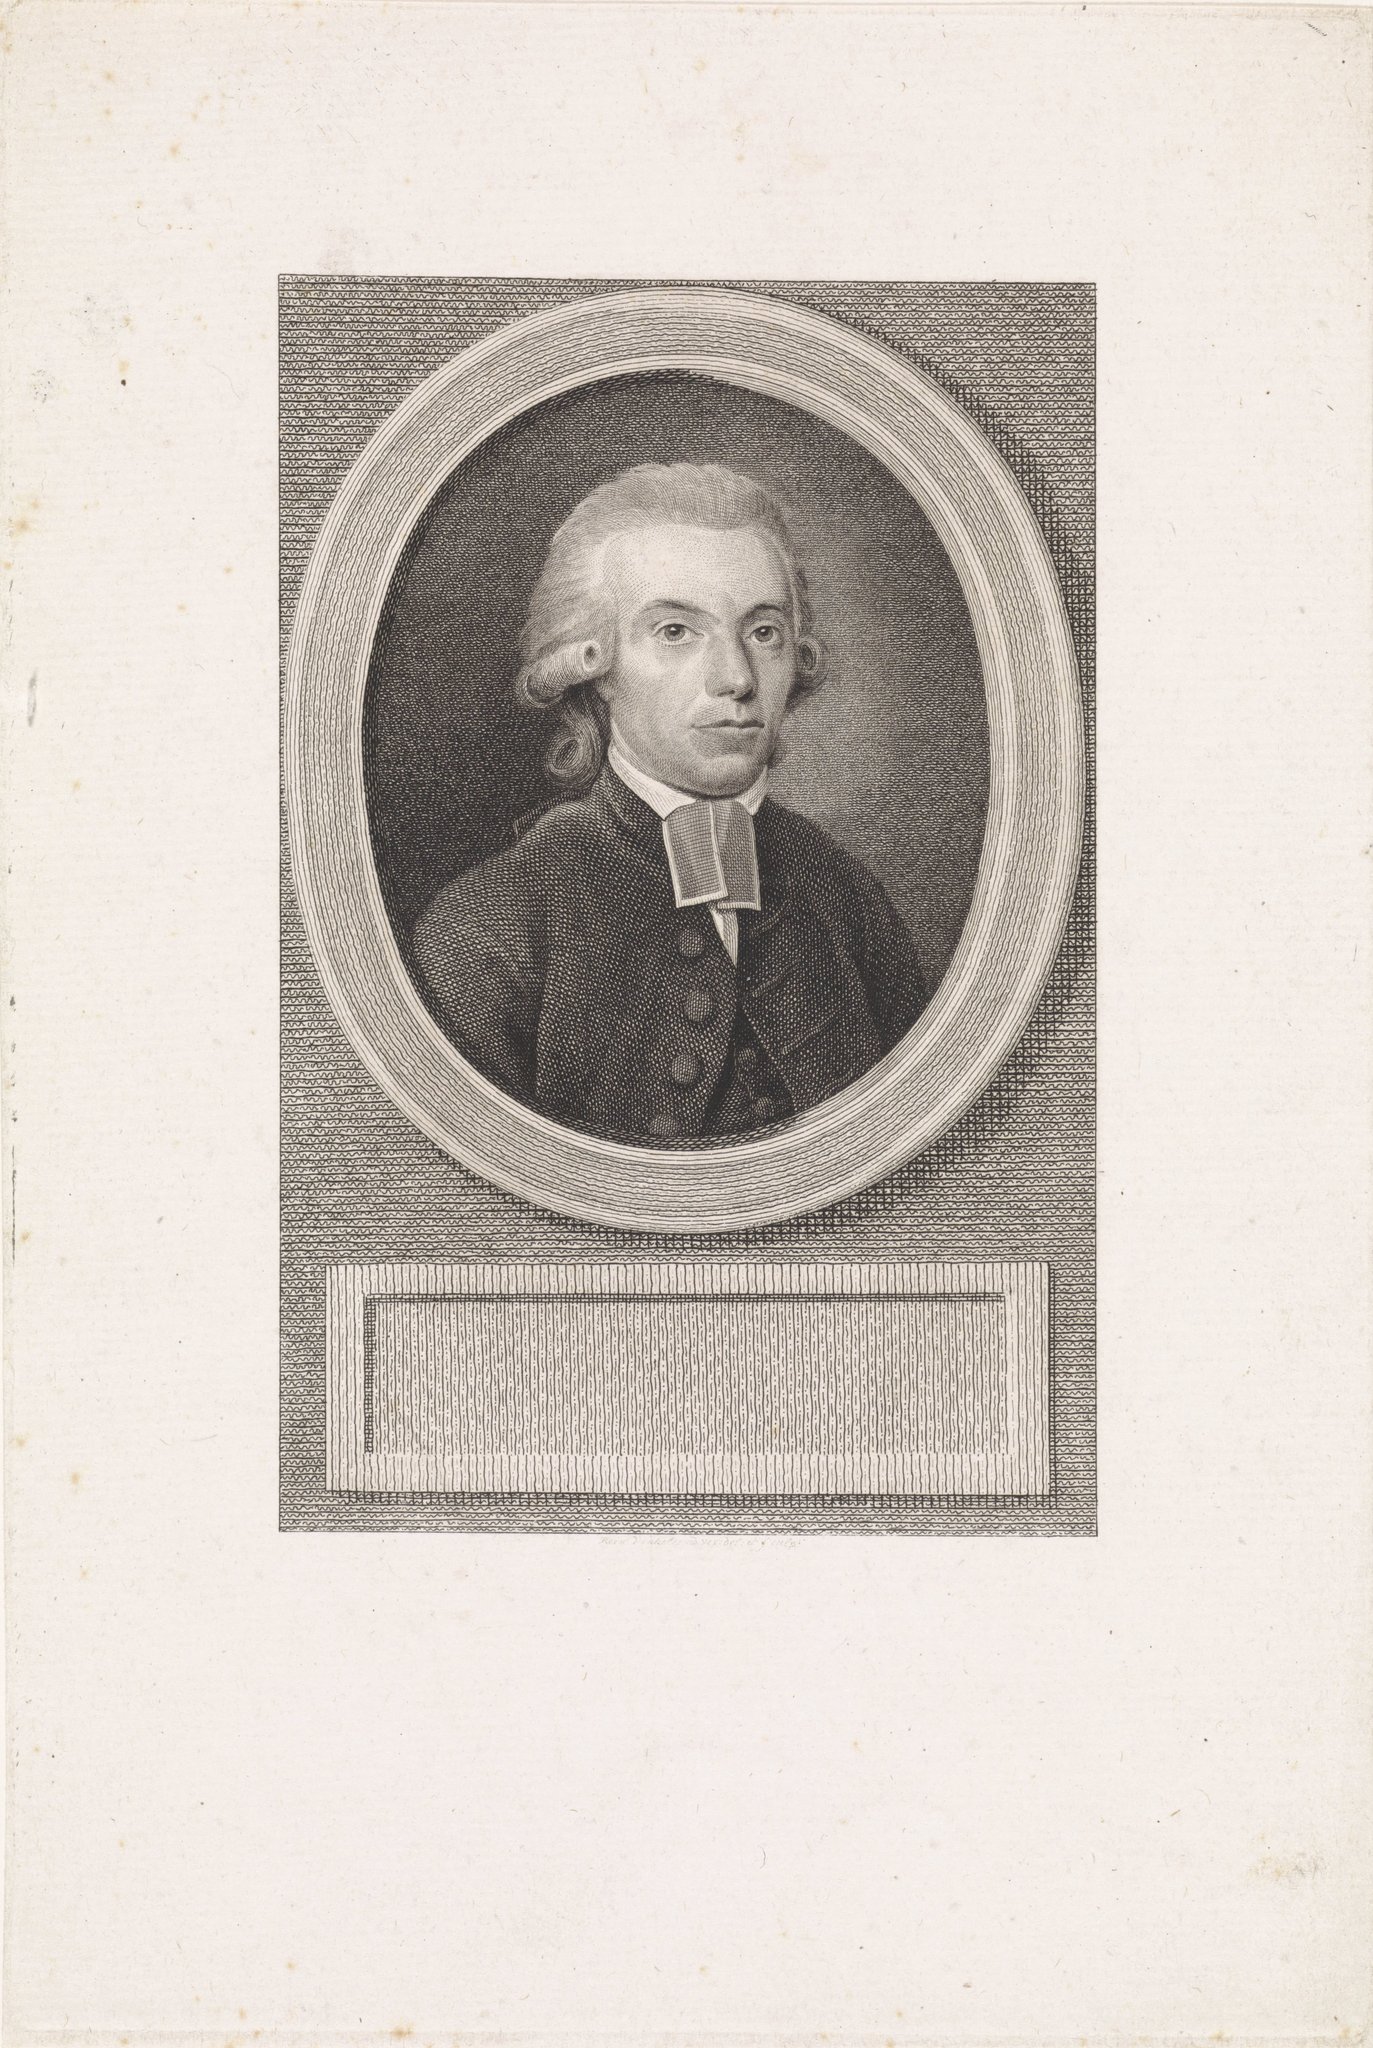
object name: print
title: Portret van Martinus Stuart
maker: reinier vinkeles (i)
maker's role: draughtsman, print maker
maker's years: 1741-1816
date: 1793-1816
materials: paper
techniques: engraving, etching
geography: amsterdam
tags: rotterdam, amsterdam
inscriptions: collector's mark: Lugt 2228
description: Portret van Martinus Stuart, predikant en schrijver te Amsterdam.